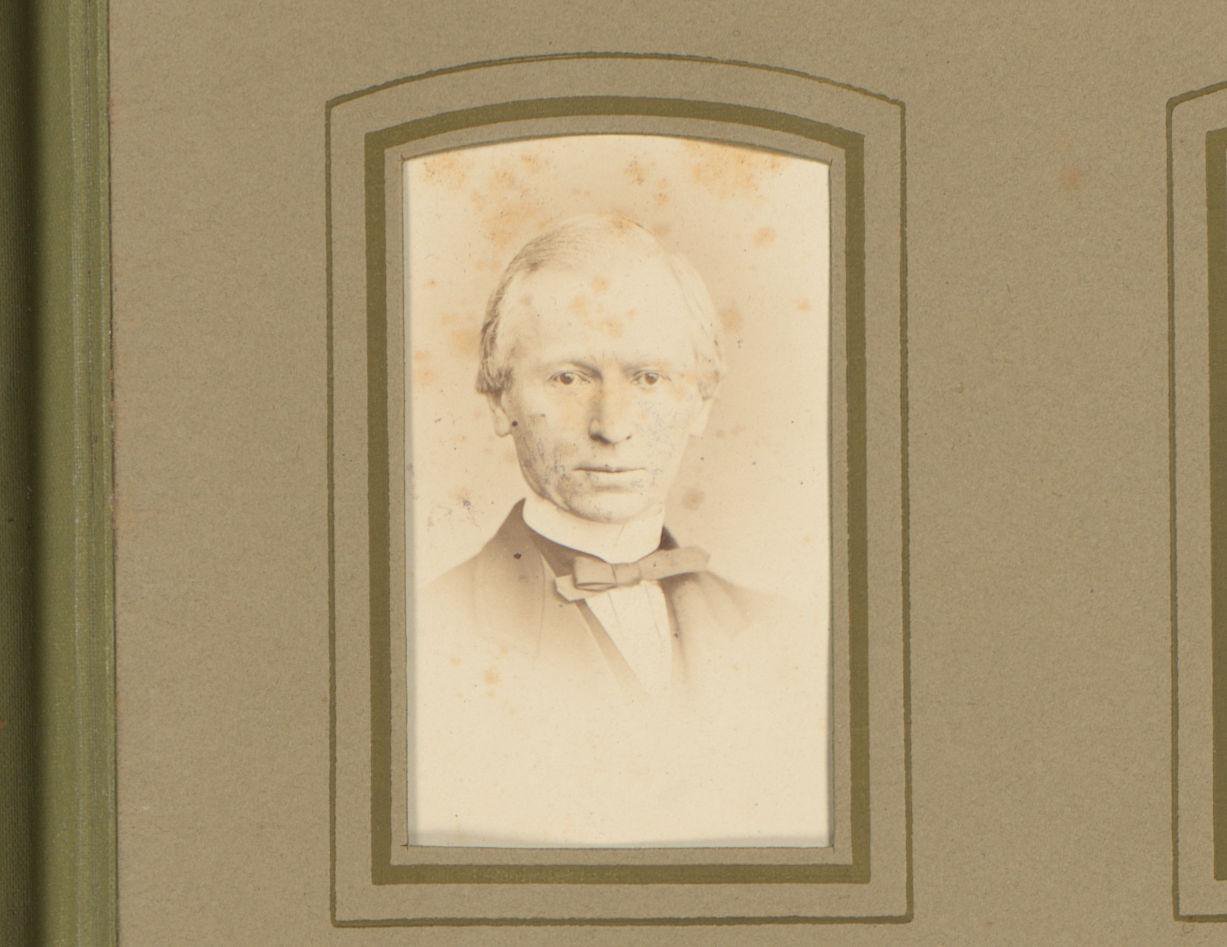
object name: photograph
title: Portret van een man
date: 1860-1884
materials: cardboard, photographic support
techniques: albumen print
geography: netherlands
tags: historical persons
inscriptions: inscription: ‘PHOTOGr ATELIER/ WEGNER & MOTTU/ KALVERSTRAAT/ over den Heyligenweg D. 26/ AMSTERDAM/ LEYDSCHE STRAATWEG/ Buiten Cathrynen/ UTRECHT’, number: ‘1’